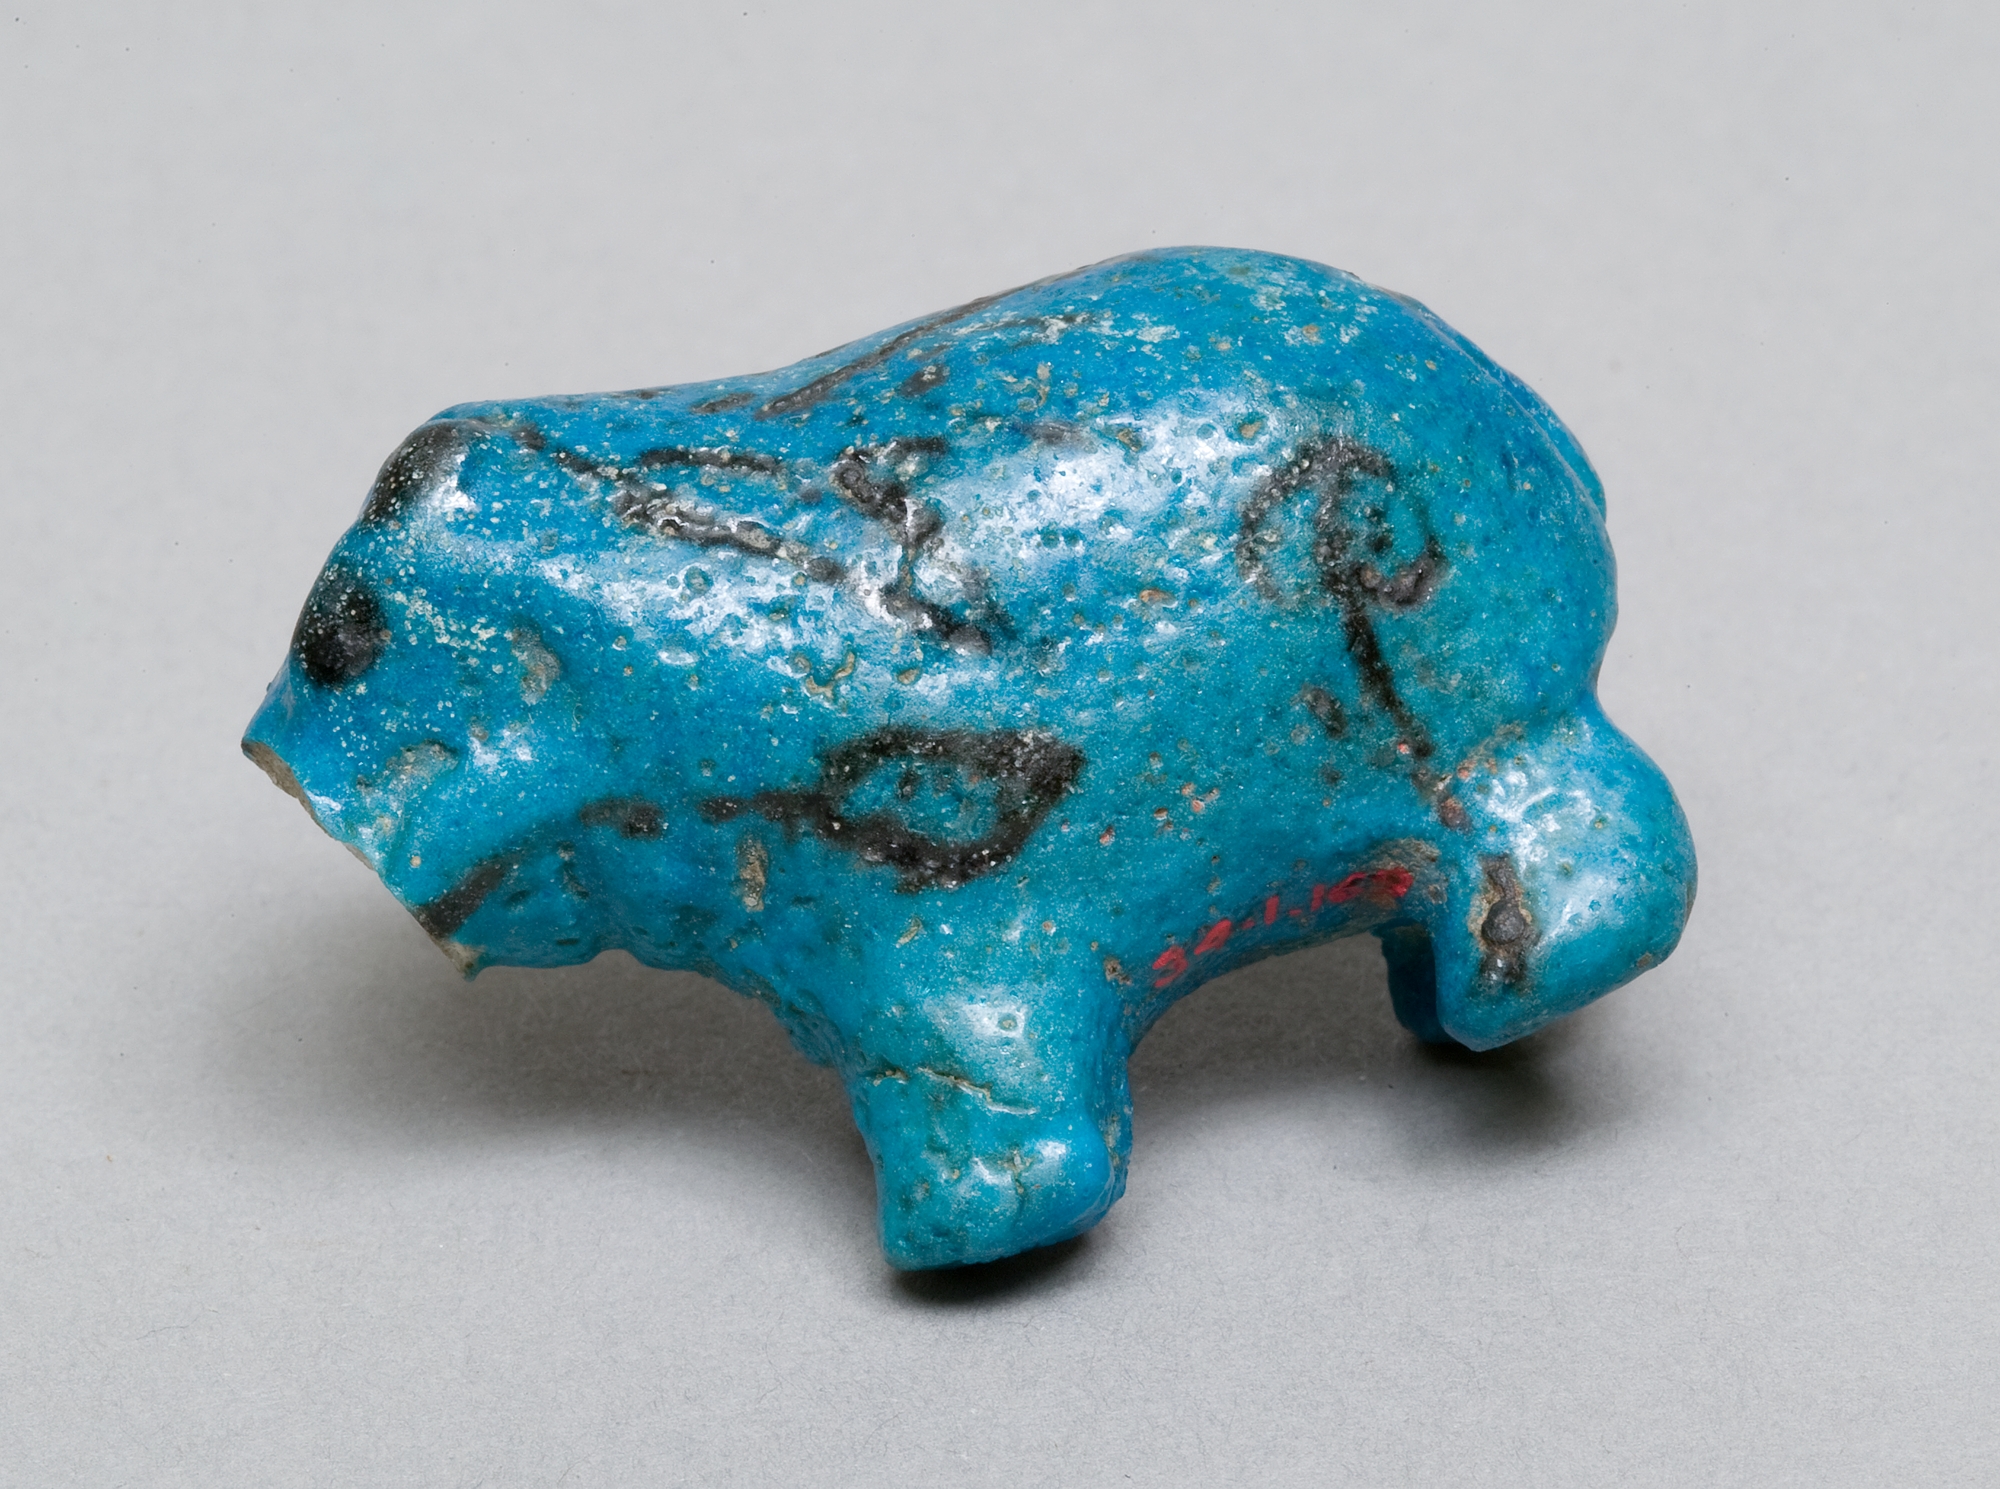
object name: figurine, hippopotamus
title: Hippopotamus figurine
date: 1981-1640 BCE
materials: faience, glaze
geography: egypt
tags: hippos